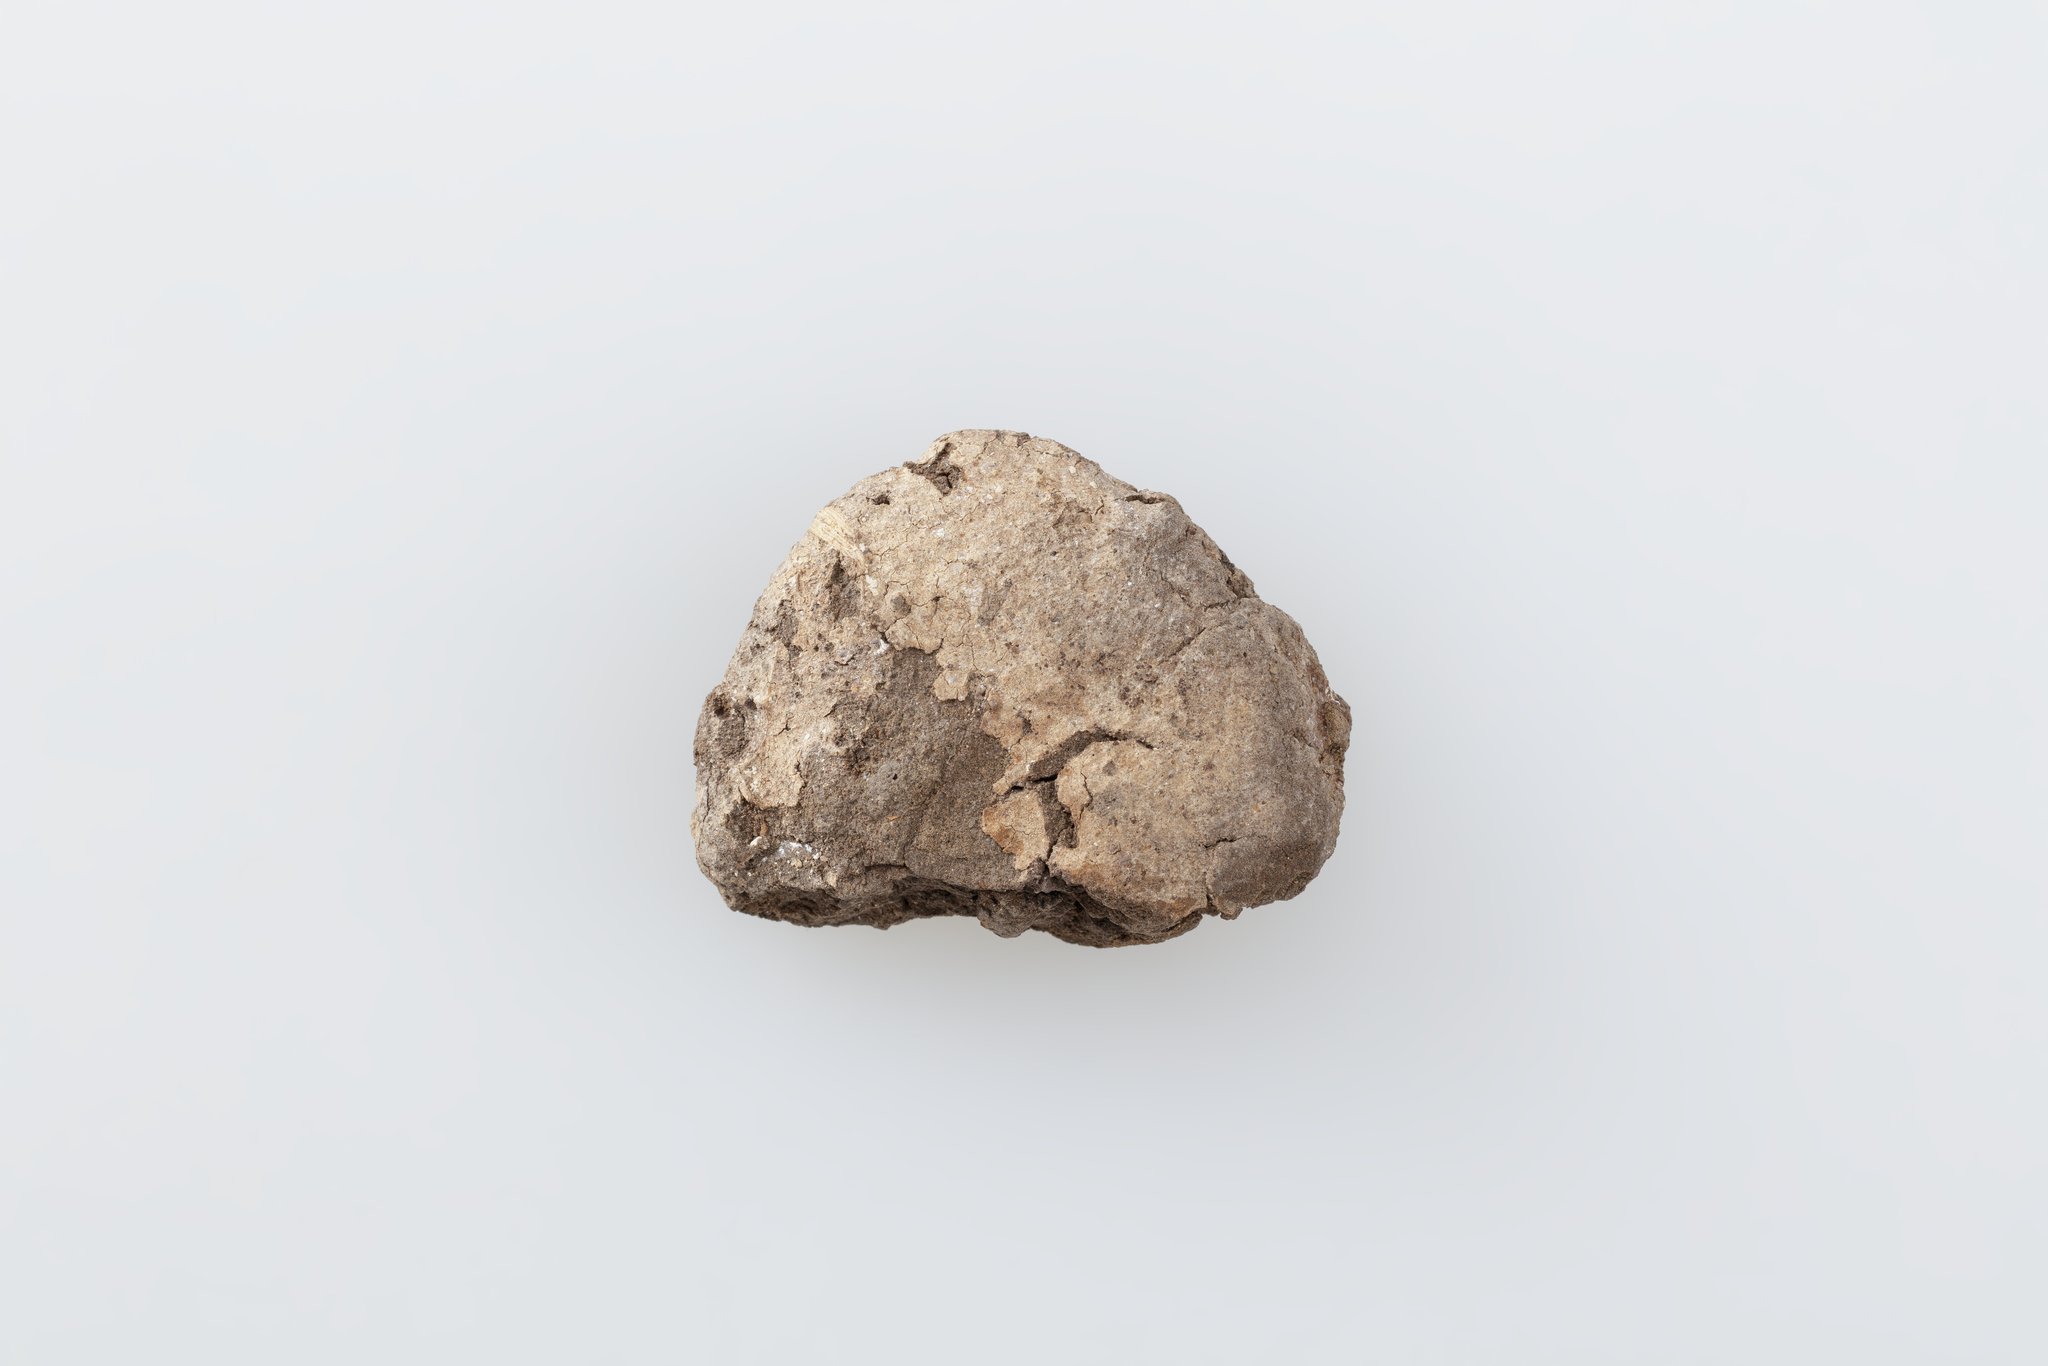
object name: model food offering, cake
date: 1981-1975 BCE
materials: mud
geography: egypt